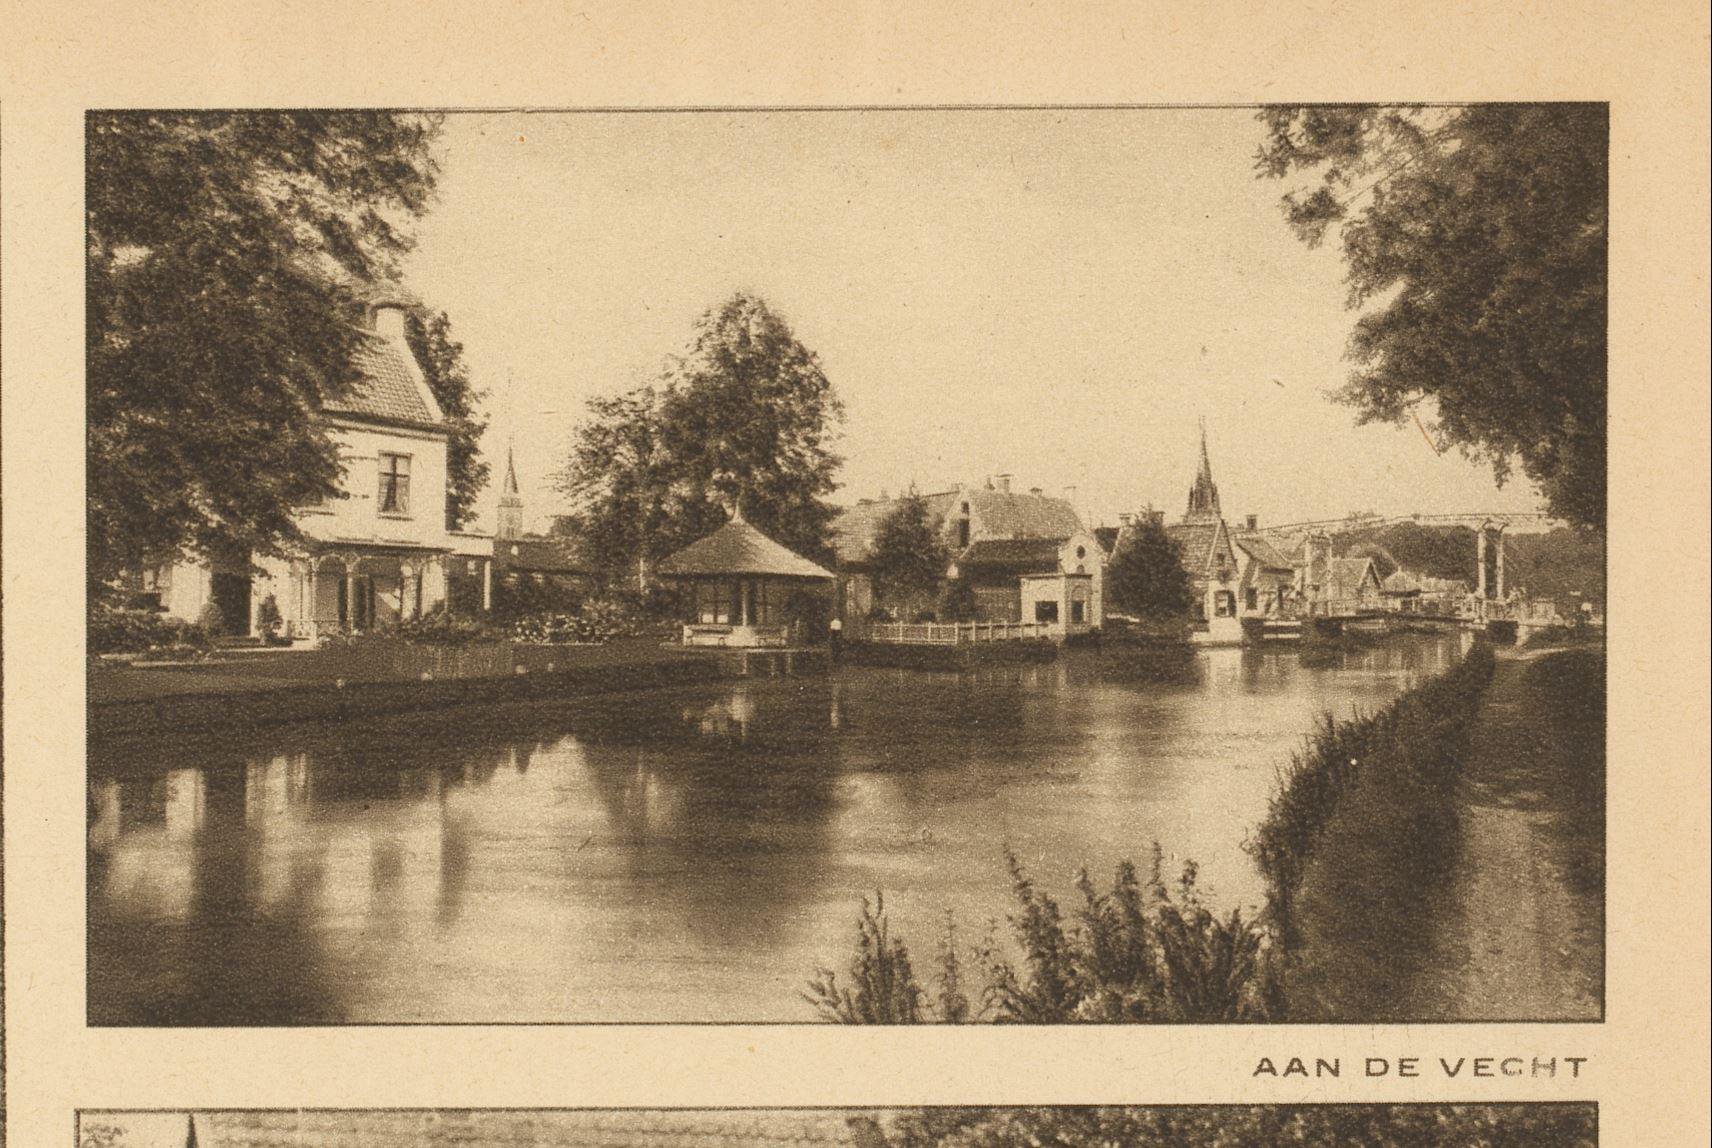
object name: album leaf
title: Aan de vecht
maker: Anonymous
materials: paper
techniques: rotogravure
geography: breukelen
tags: prospect of village, silhouette of village, canals, waters (in village), vecht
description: Deze prent maakt deel uit van een album.